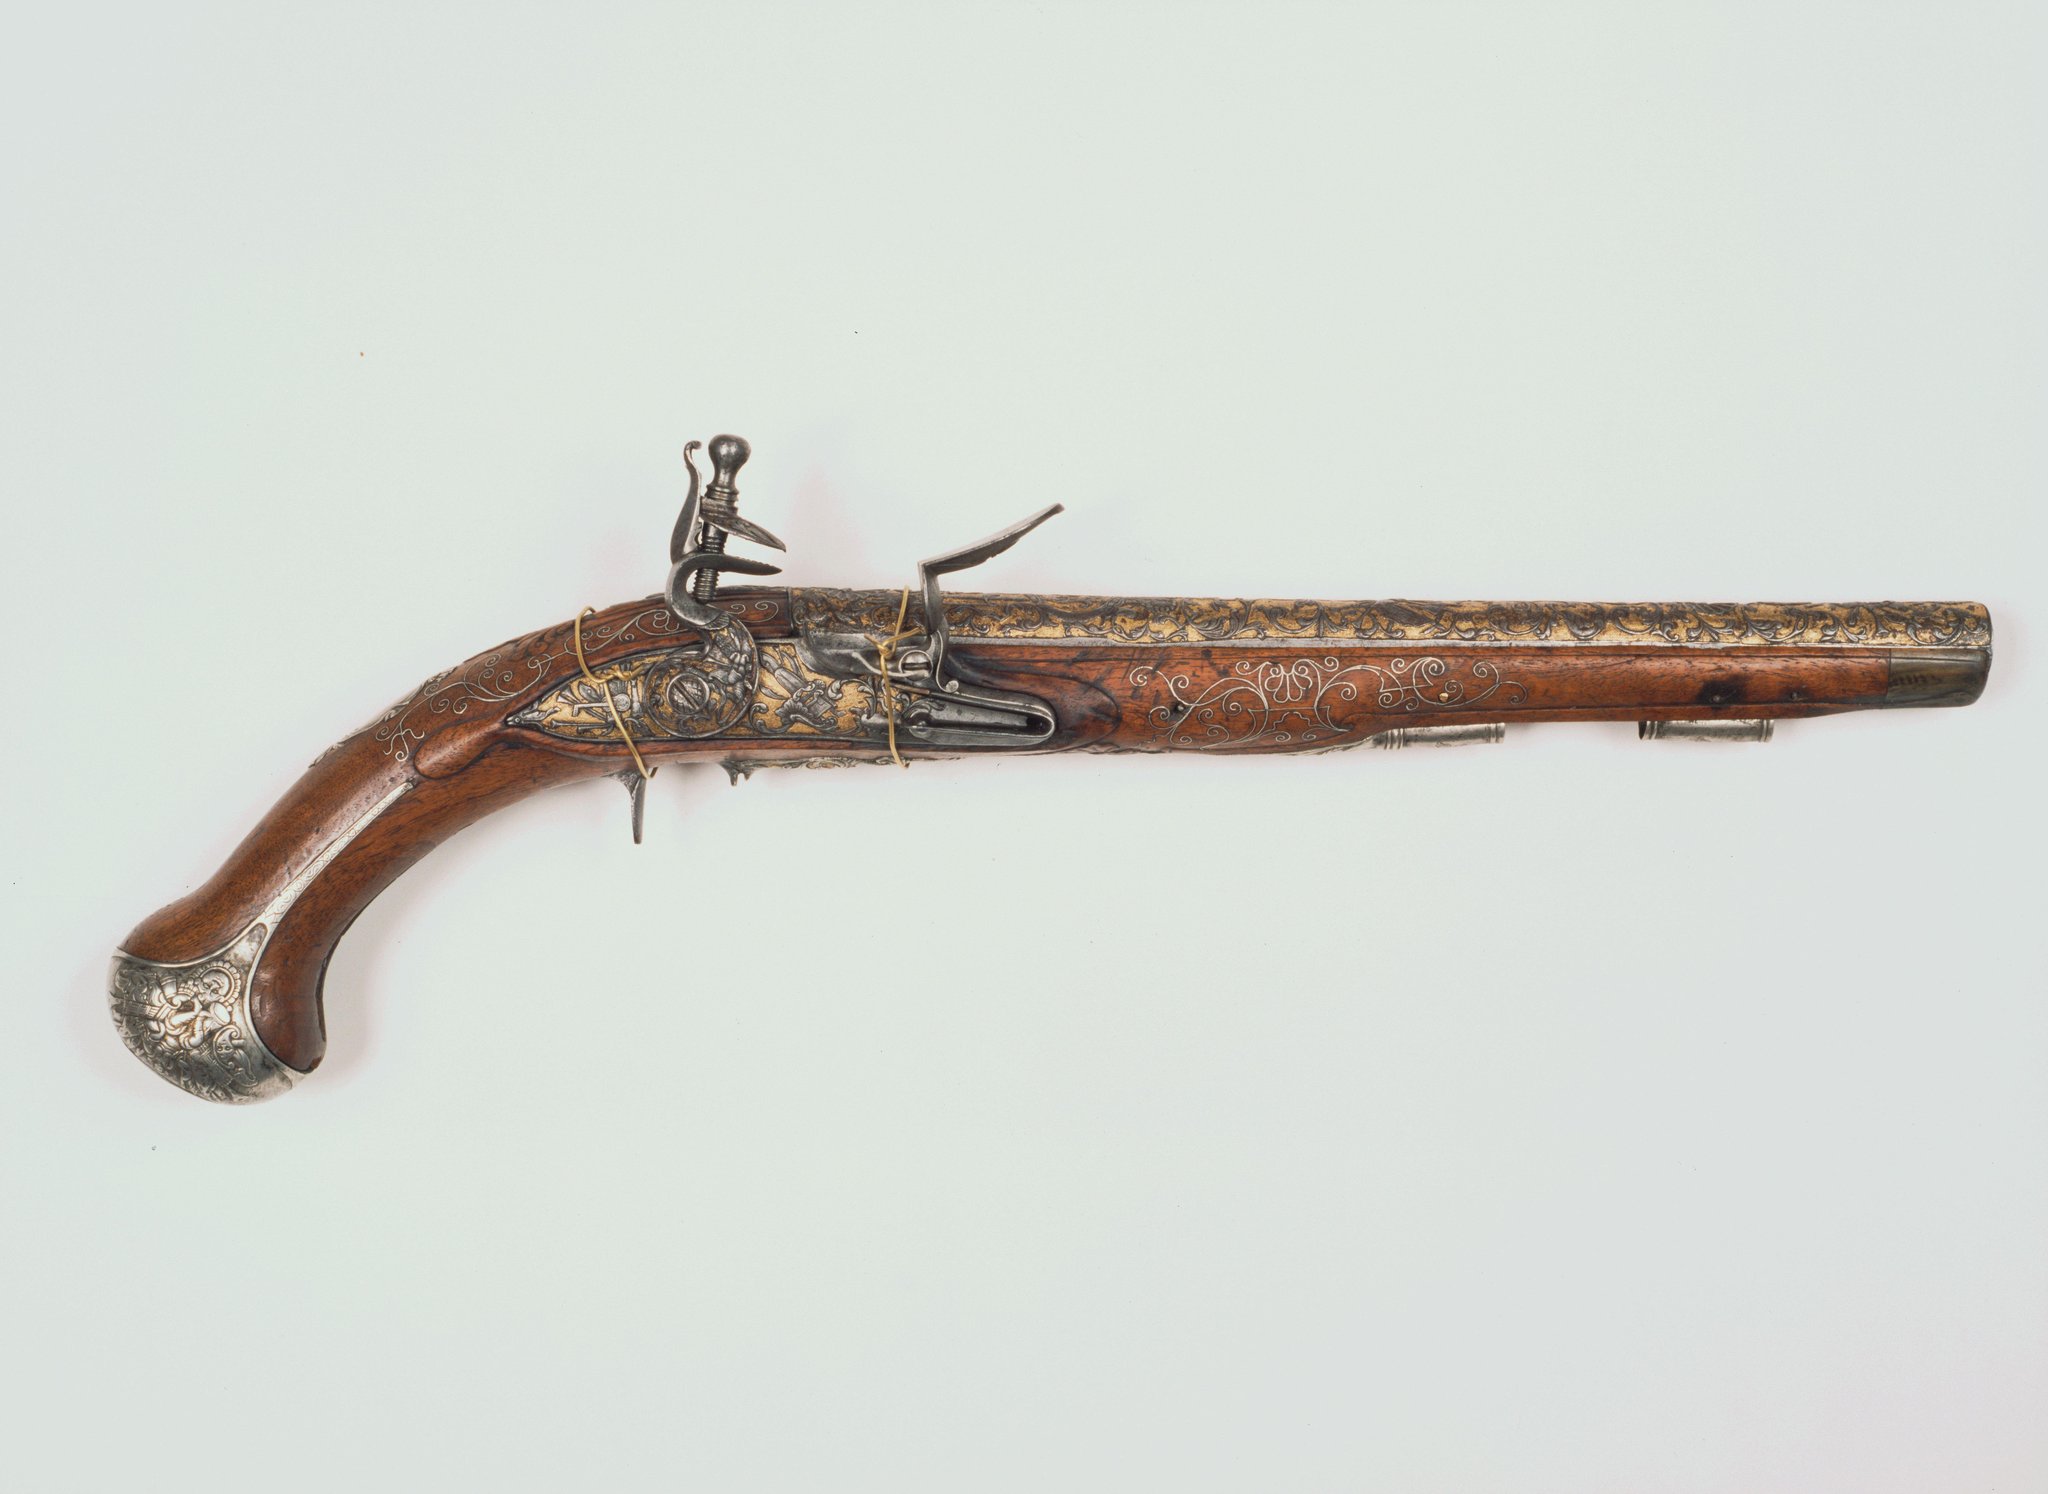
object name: pistol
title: Ruiterpistool met rijk geornamenteerde loop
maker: Anonymous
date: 1725-1775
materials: gold, iron, silver, wood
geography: western europe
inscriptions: signature: ‘EP met kroon’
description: Ruiterpistool waarvan de loop rijk geciseleerd is met ornamenten op gouden grond in het genre van Bérain, waartussen een monogram E.P. (kroon erboven) (stadhoudelijke Prinsenkroon, wellicht Erfprins). De kolf is met zilver ingelegd en gedeeltelijk in zilver gevat. De eenvoudige houten laadstok is beweegbaar tussen zilveren ringen. De trekbeugel ontbreekt.